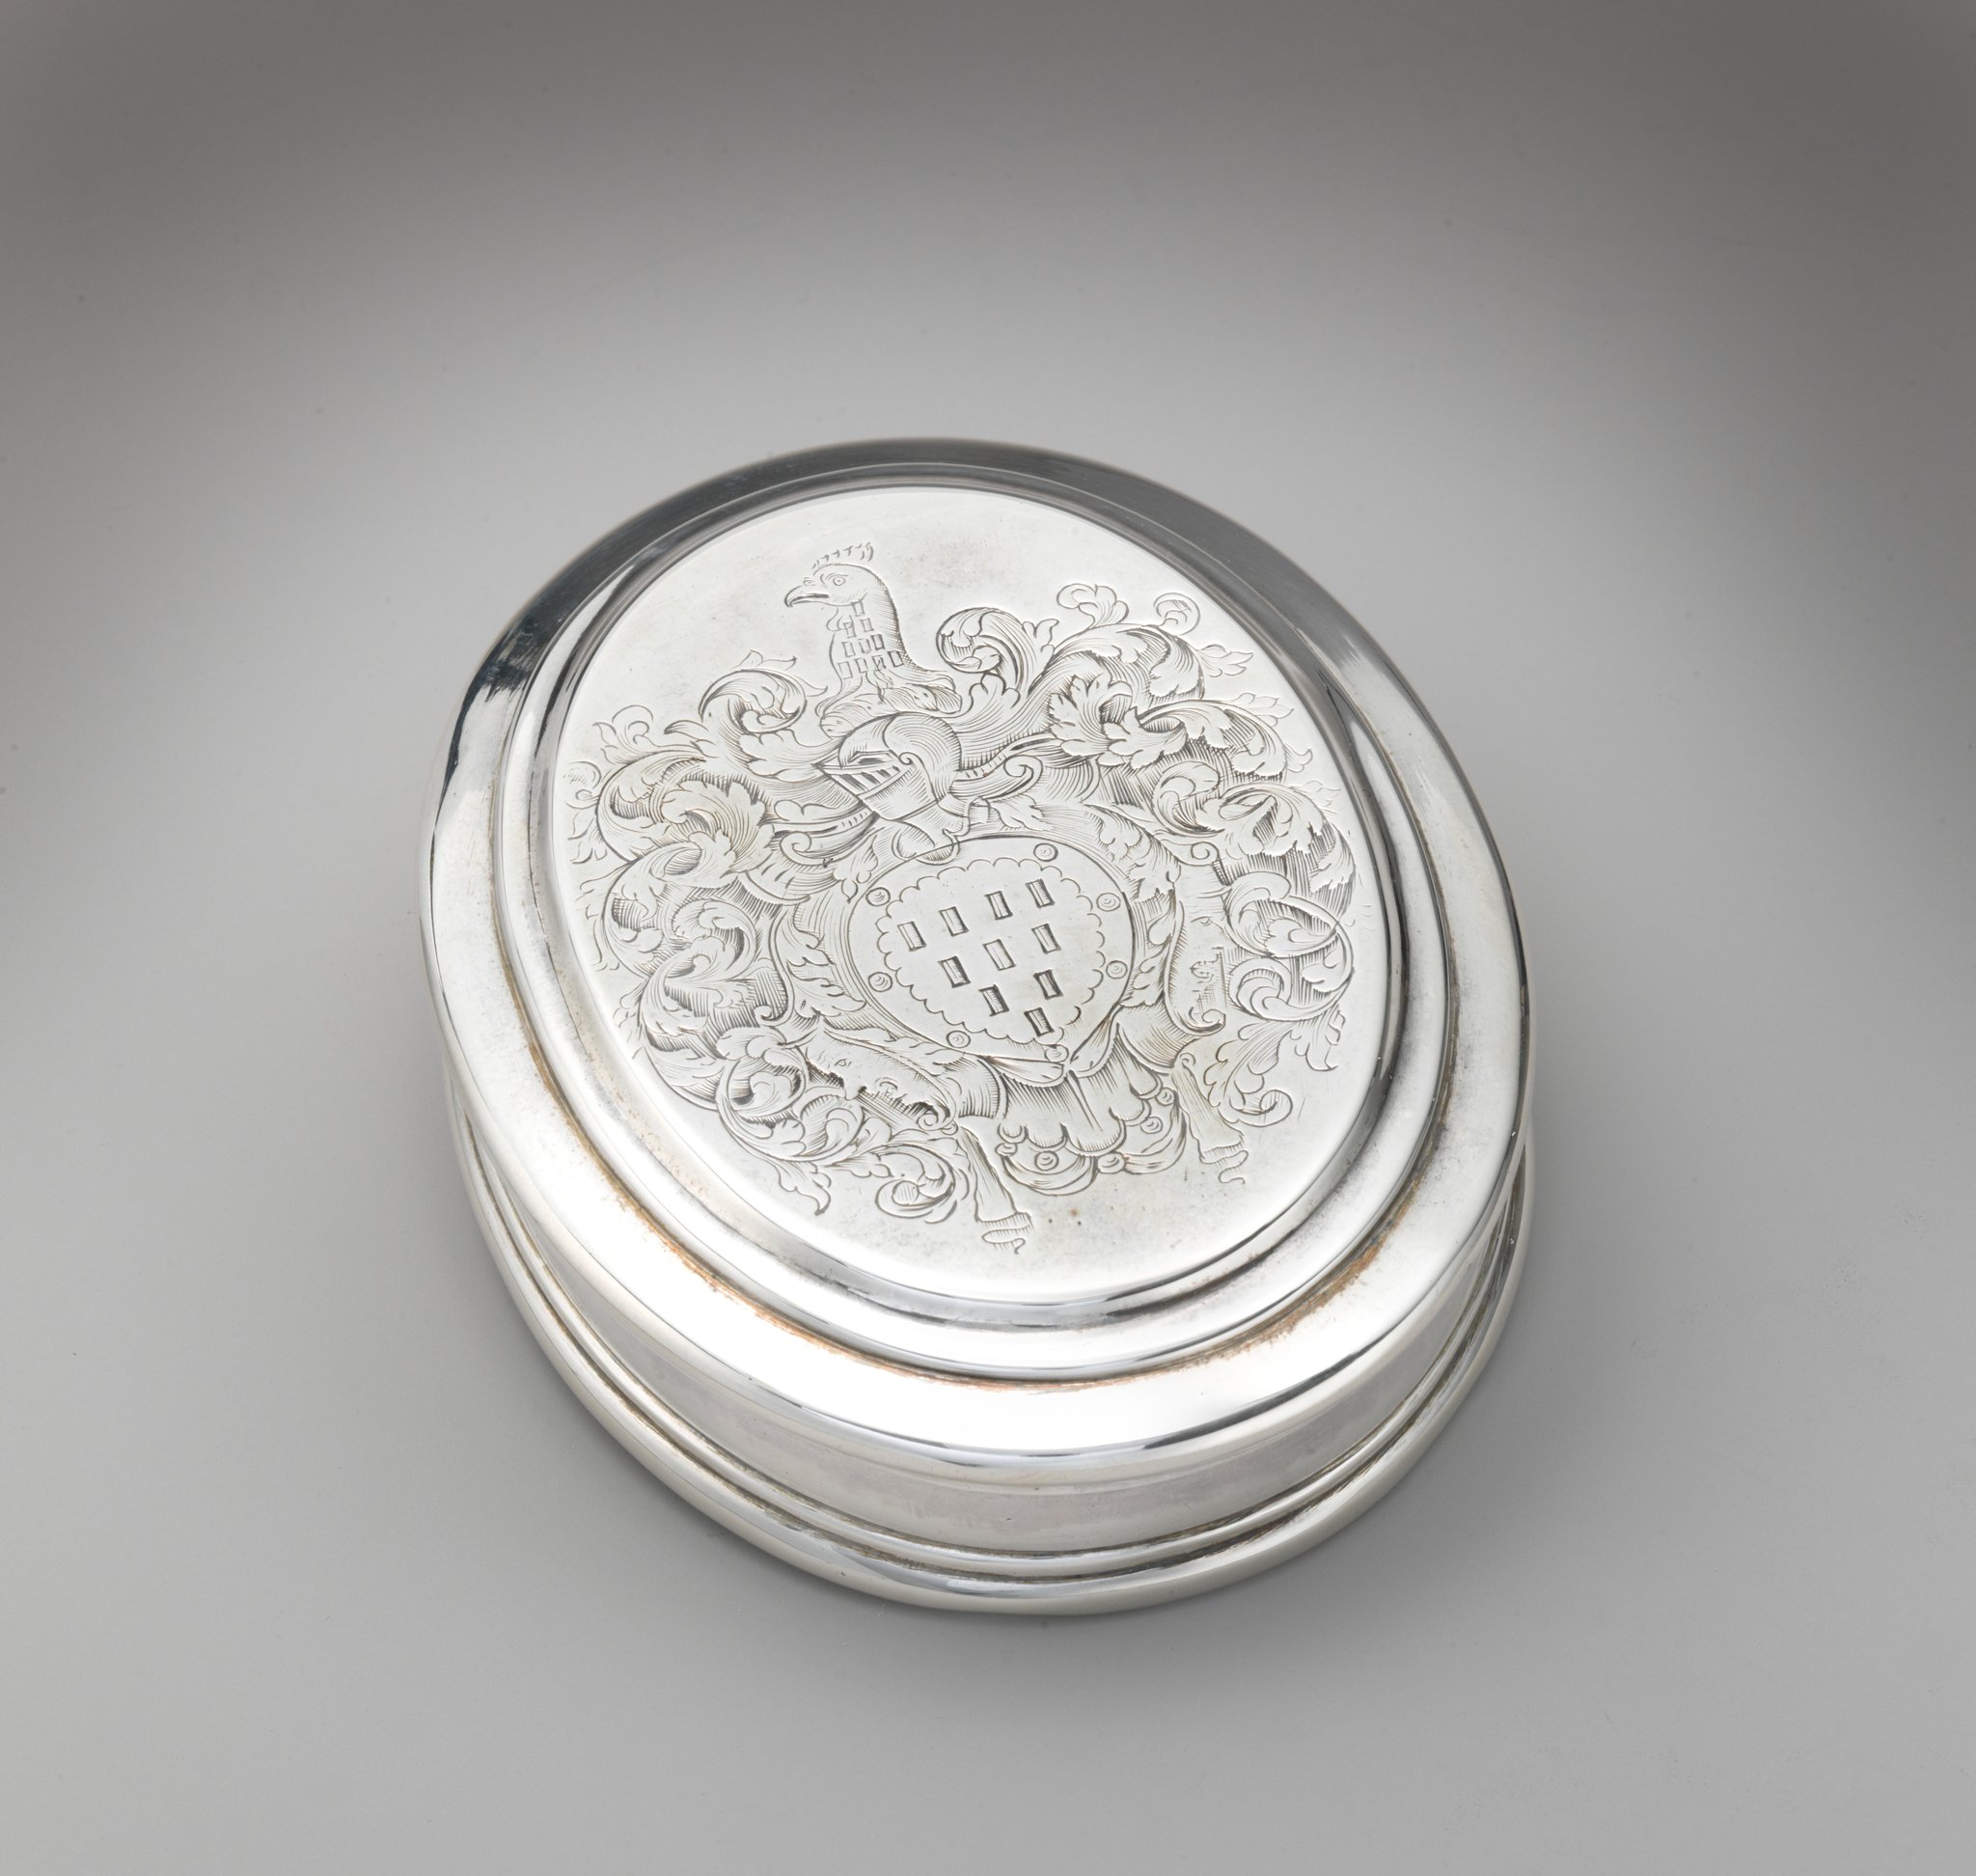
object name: tobacco box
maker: john abbott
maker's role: maker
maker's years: 1706-1720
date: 1706-1707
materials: silver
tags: birds,coat of arms